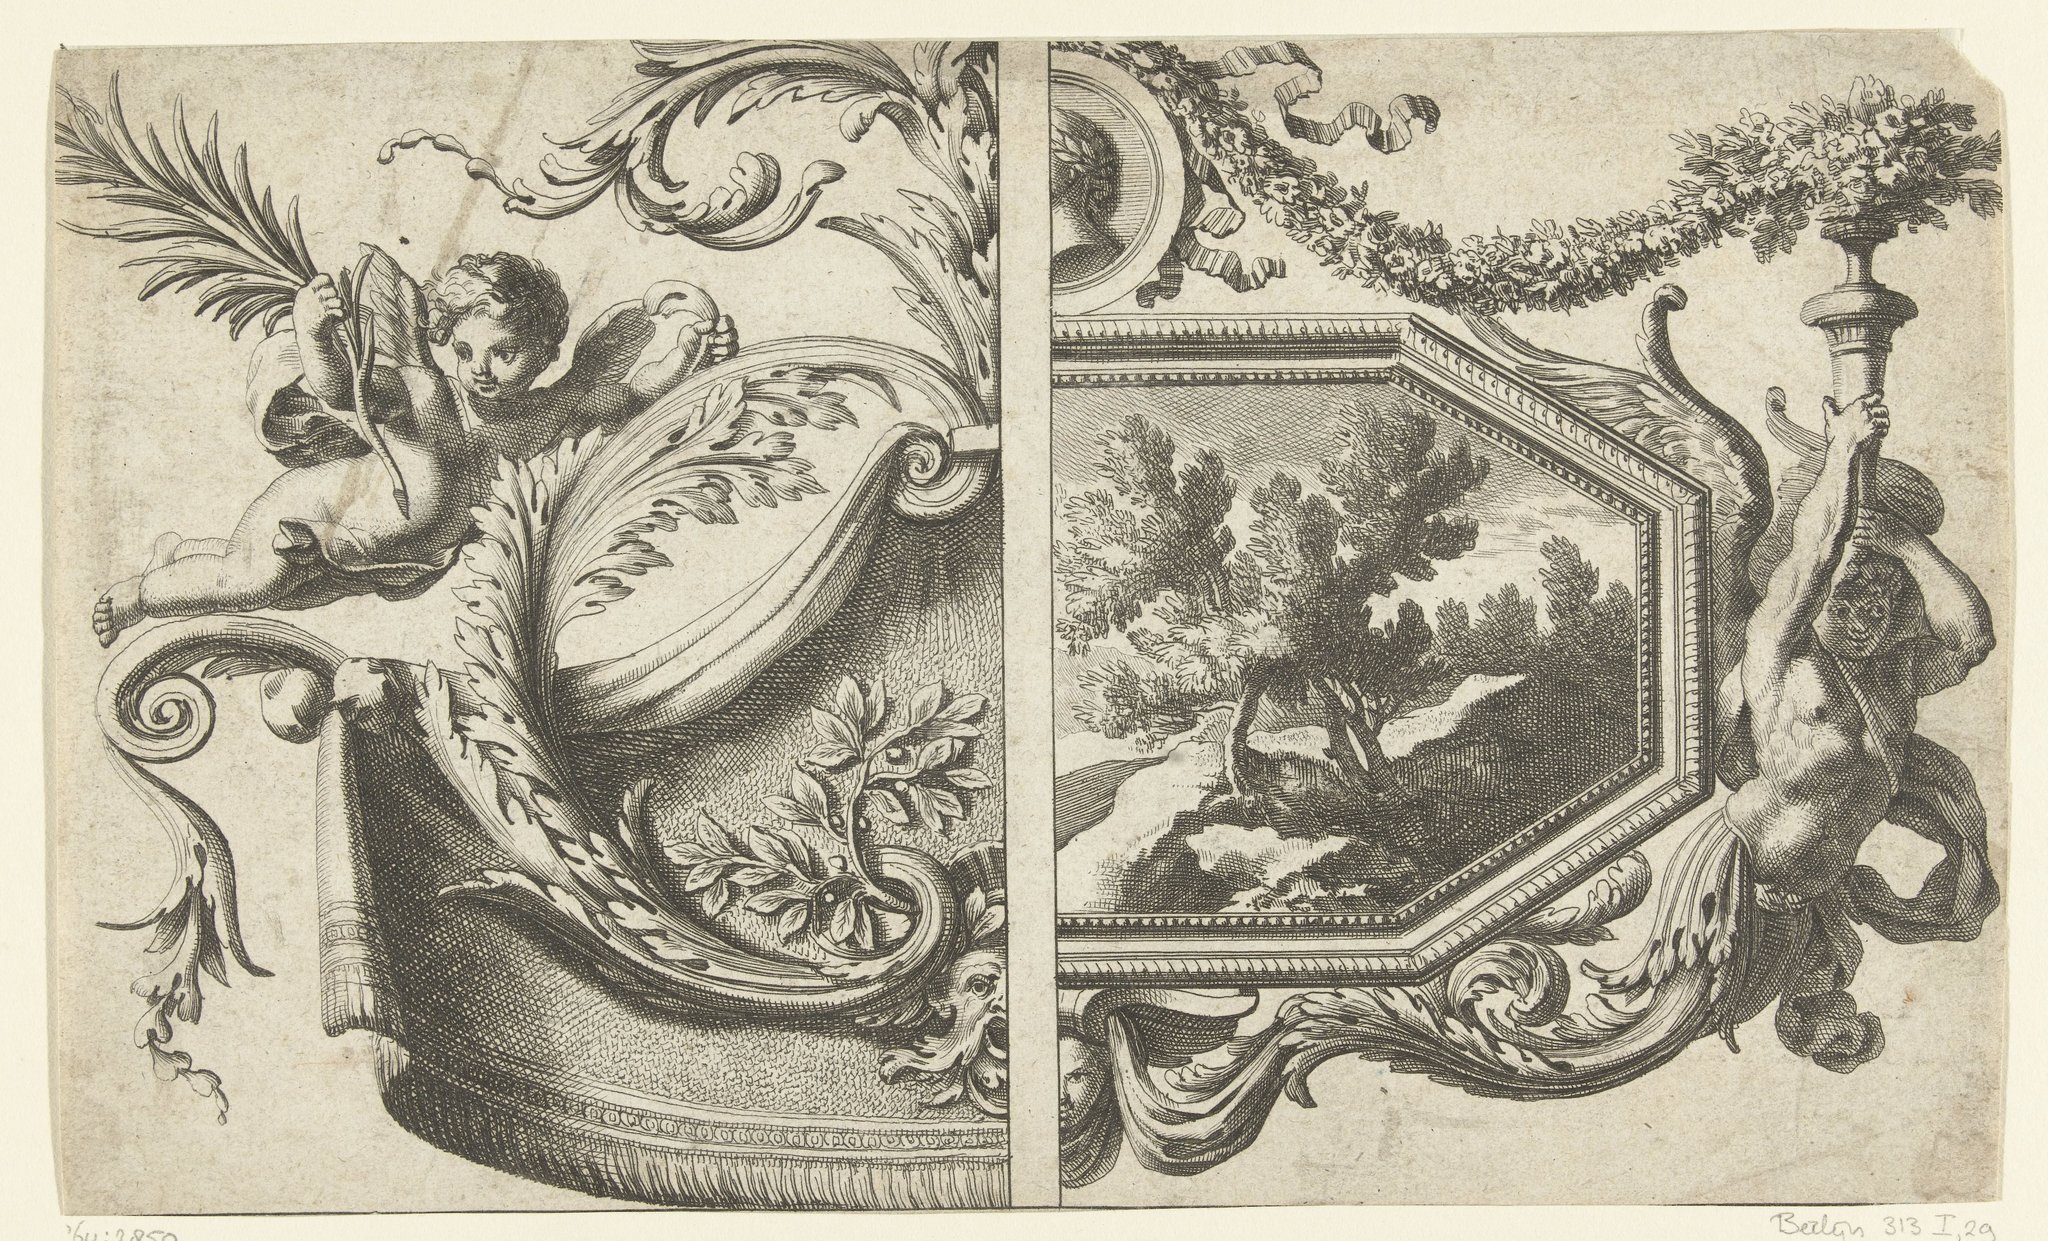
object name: ornament print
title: Liure de Panaux pour les Lambris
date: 1656-1706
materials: paper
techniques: etching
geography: france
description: Rechts is de helft van een achthoekige lijst met een landschap te zien. Blad 6 uit serie van 6 bladen met ornamentele panelen voor houten lambrisering.